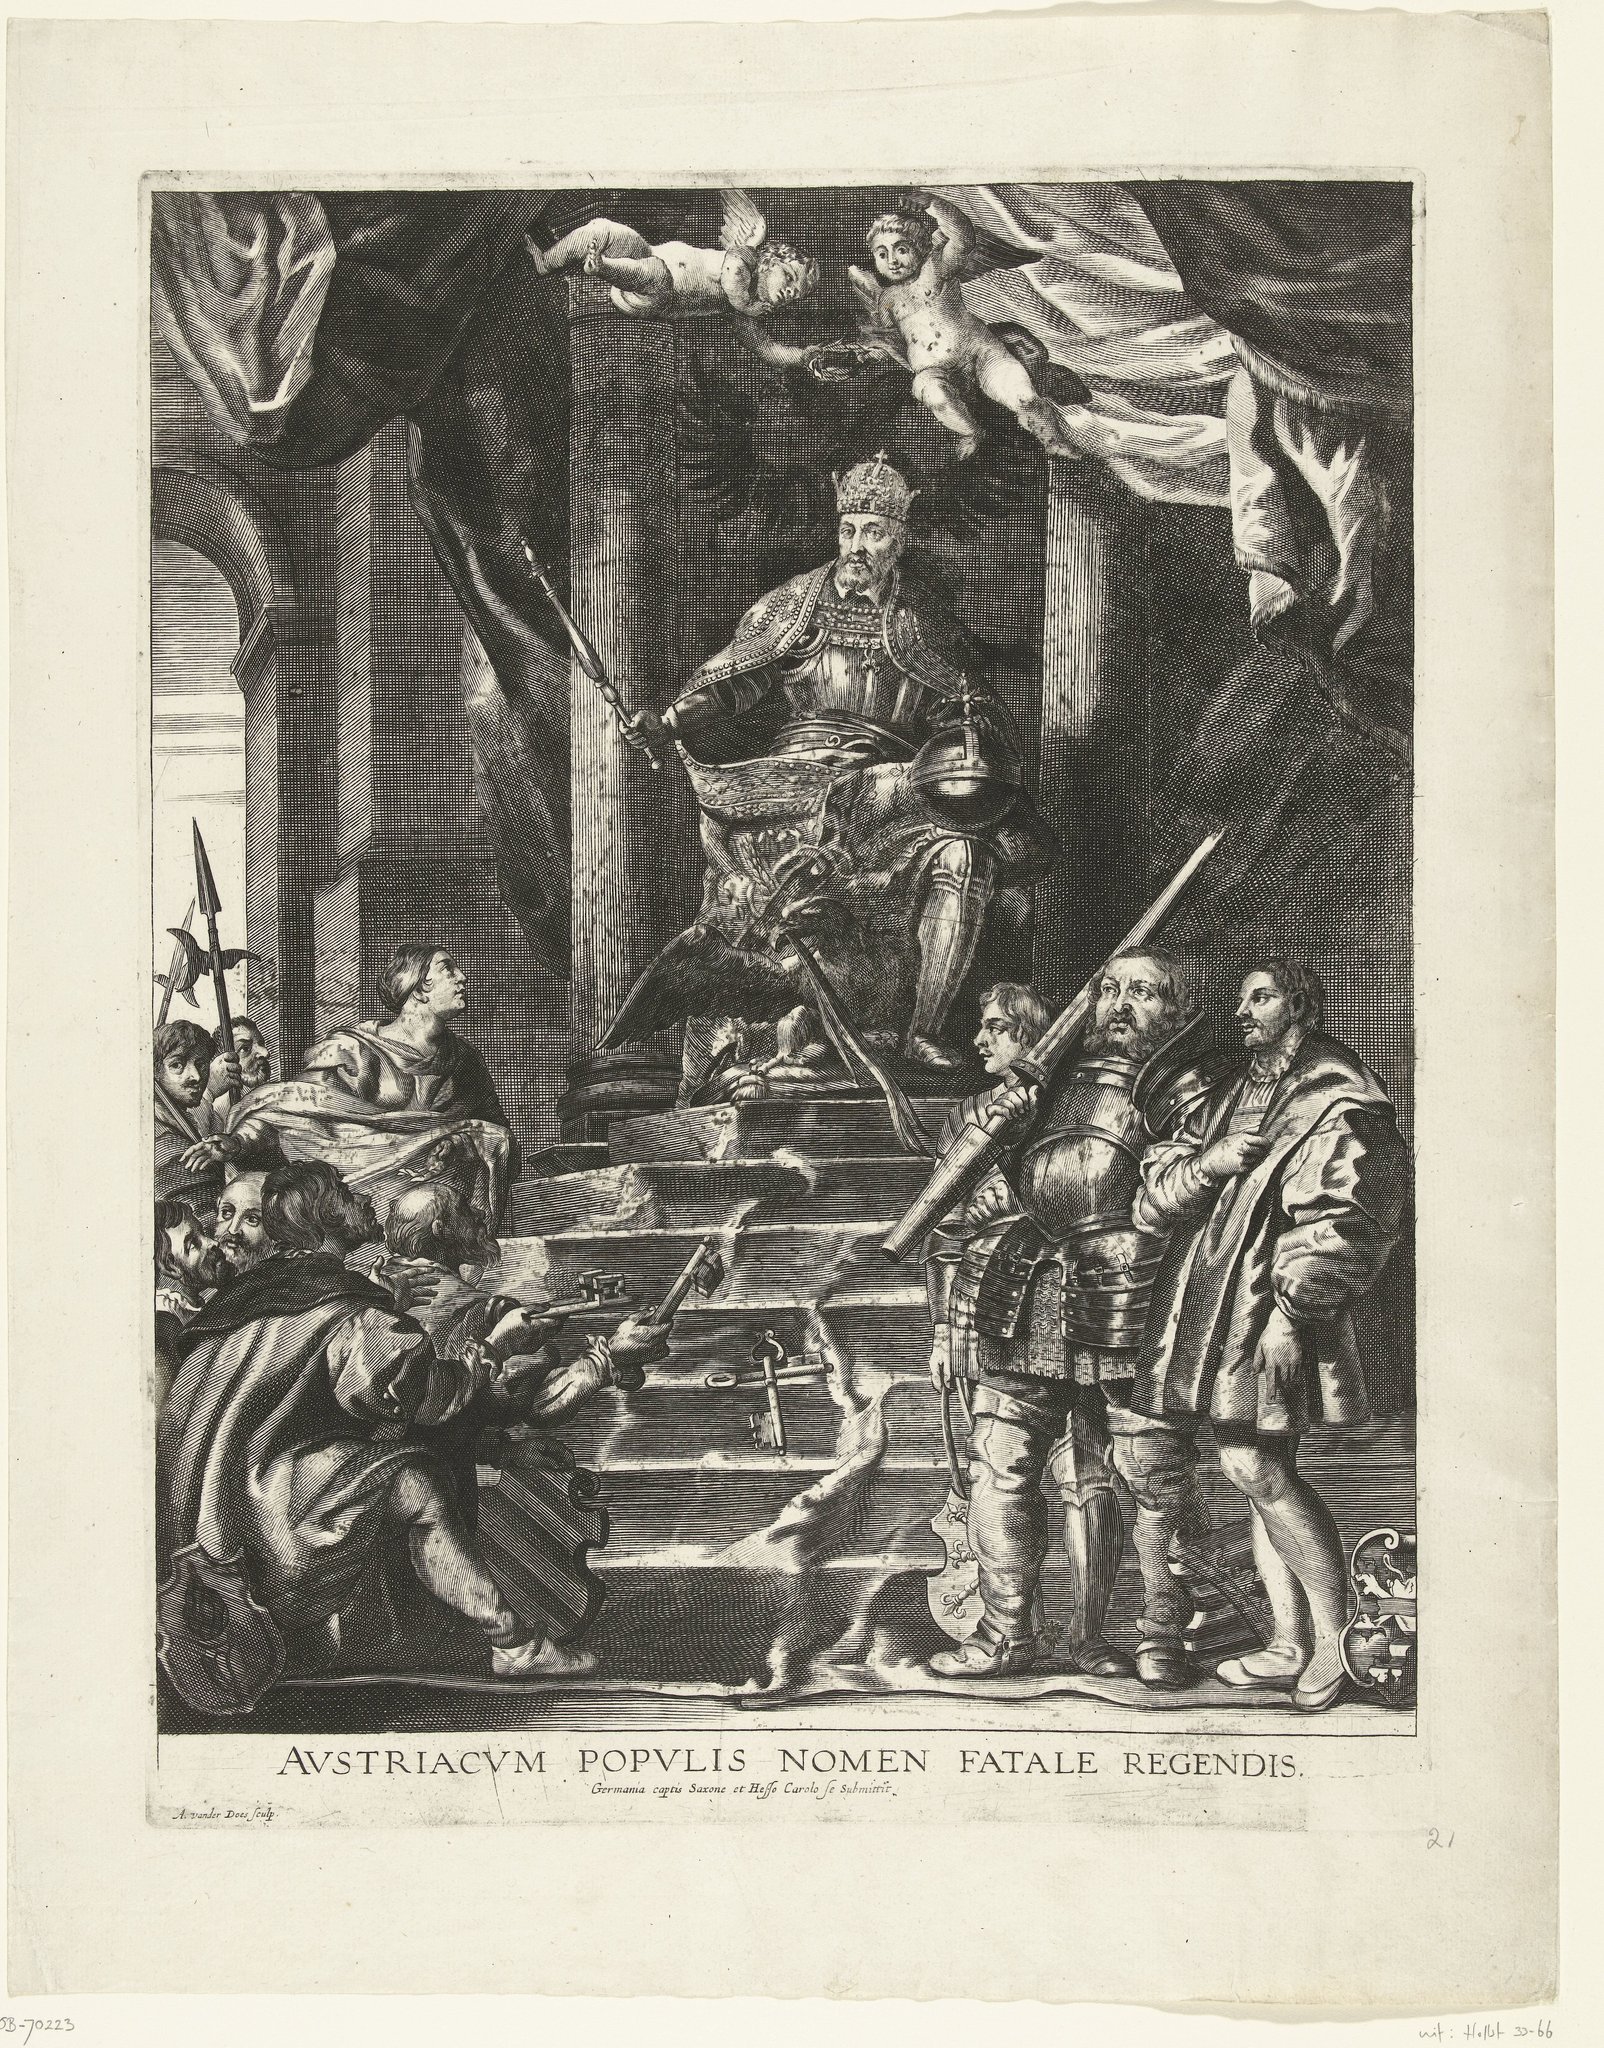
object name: history print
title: Tabula II. Germania captis Saxone & Hesso Carolo se submittit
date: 1635-1636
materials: paper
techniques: engraving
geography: southern netherlands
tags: ghent, charles v (holy roman emperor and king of spain), brussels, landvoogd der zuidelijke nederlanden ferdinand van oostenrijk, triumphal arch, surrender of keys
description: Opstandige Duitse protestantse vorsten van Saksen en Hessen overwonnen door Karel V, knielen aan de voeten van zijn troon en bieden hem de sleutels aan. Voorstelling centraal op de voorzijde van de triomfpoort Arcus Caroli op de Vrijdagsmark. Blad nr. 21 in een geheel van 42 platen die de uitgave van de beschrijving van de intocht van de Kardinaal Infant Ferdinand van Oostenrijk te Gent op 28 januari 1635 als de nieuwe landvoogd voor de Spaanse Nederlanden illustreren.